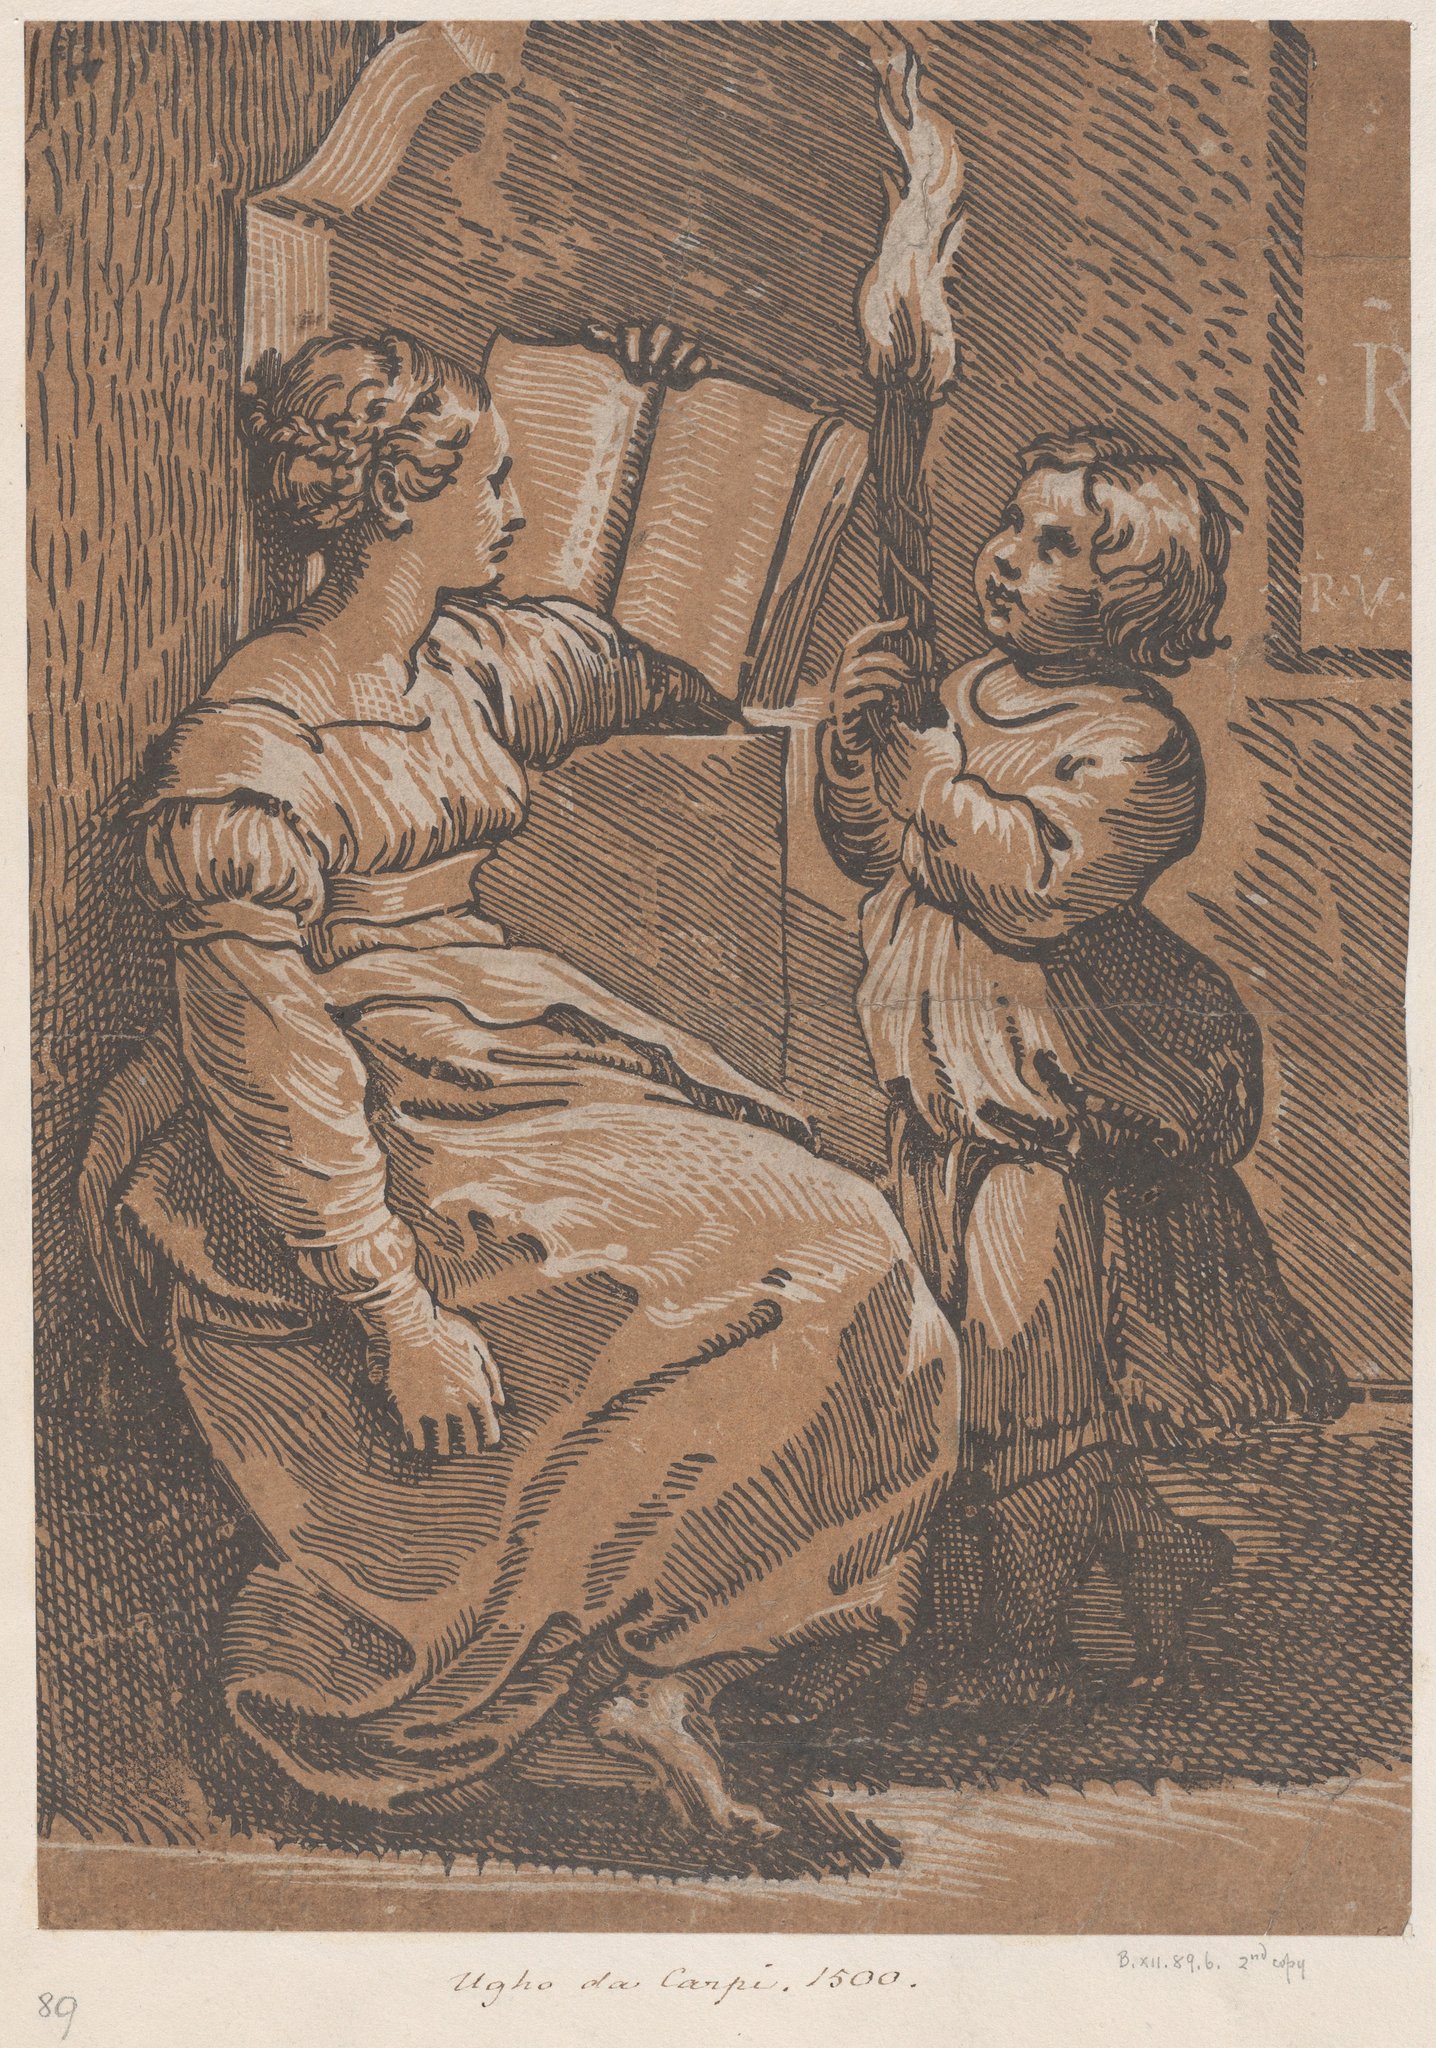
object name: print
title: A Sibyl Reading a book facing right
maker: ugo da carpi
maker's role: artist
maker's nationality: italian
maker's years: 1480-1532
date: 1517-1518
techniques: woodcut, printing